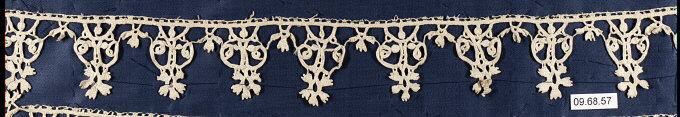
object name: edging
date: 1600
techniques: lace